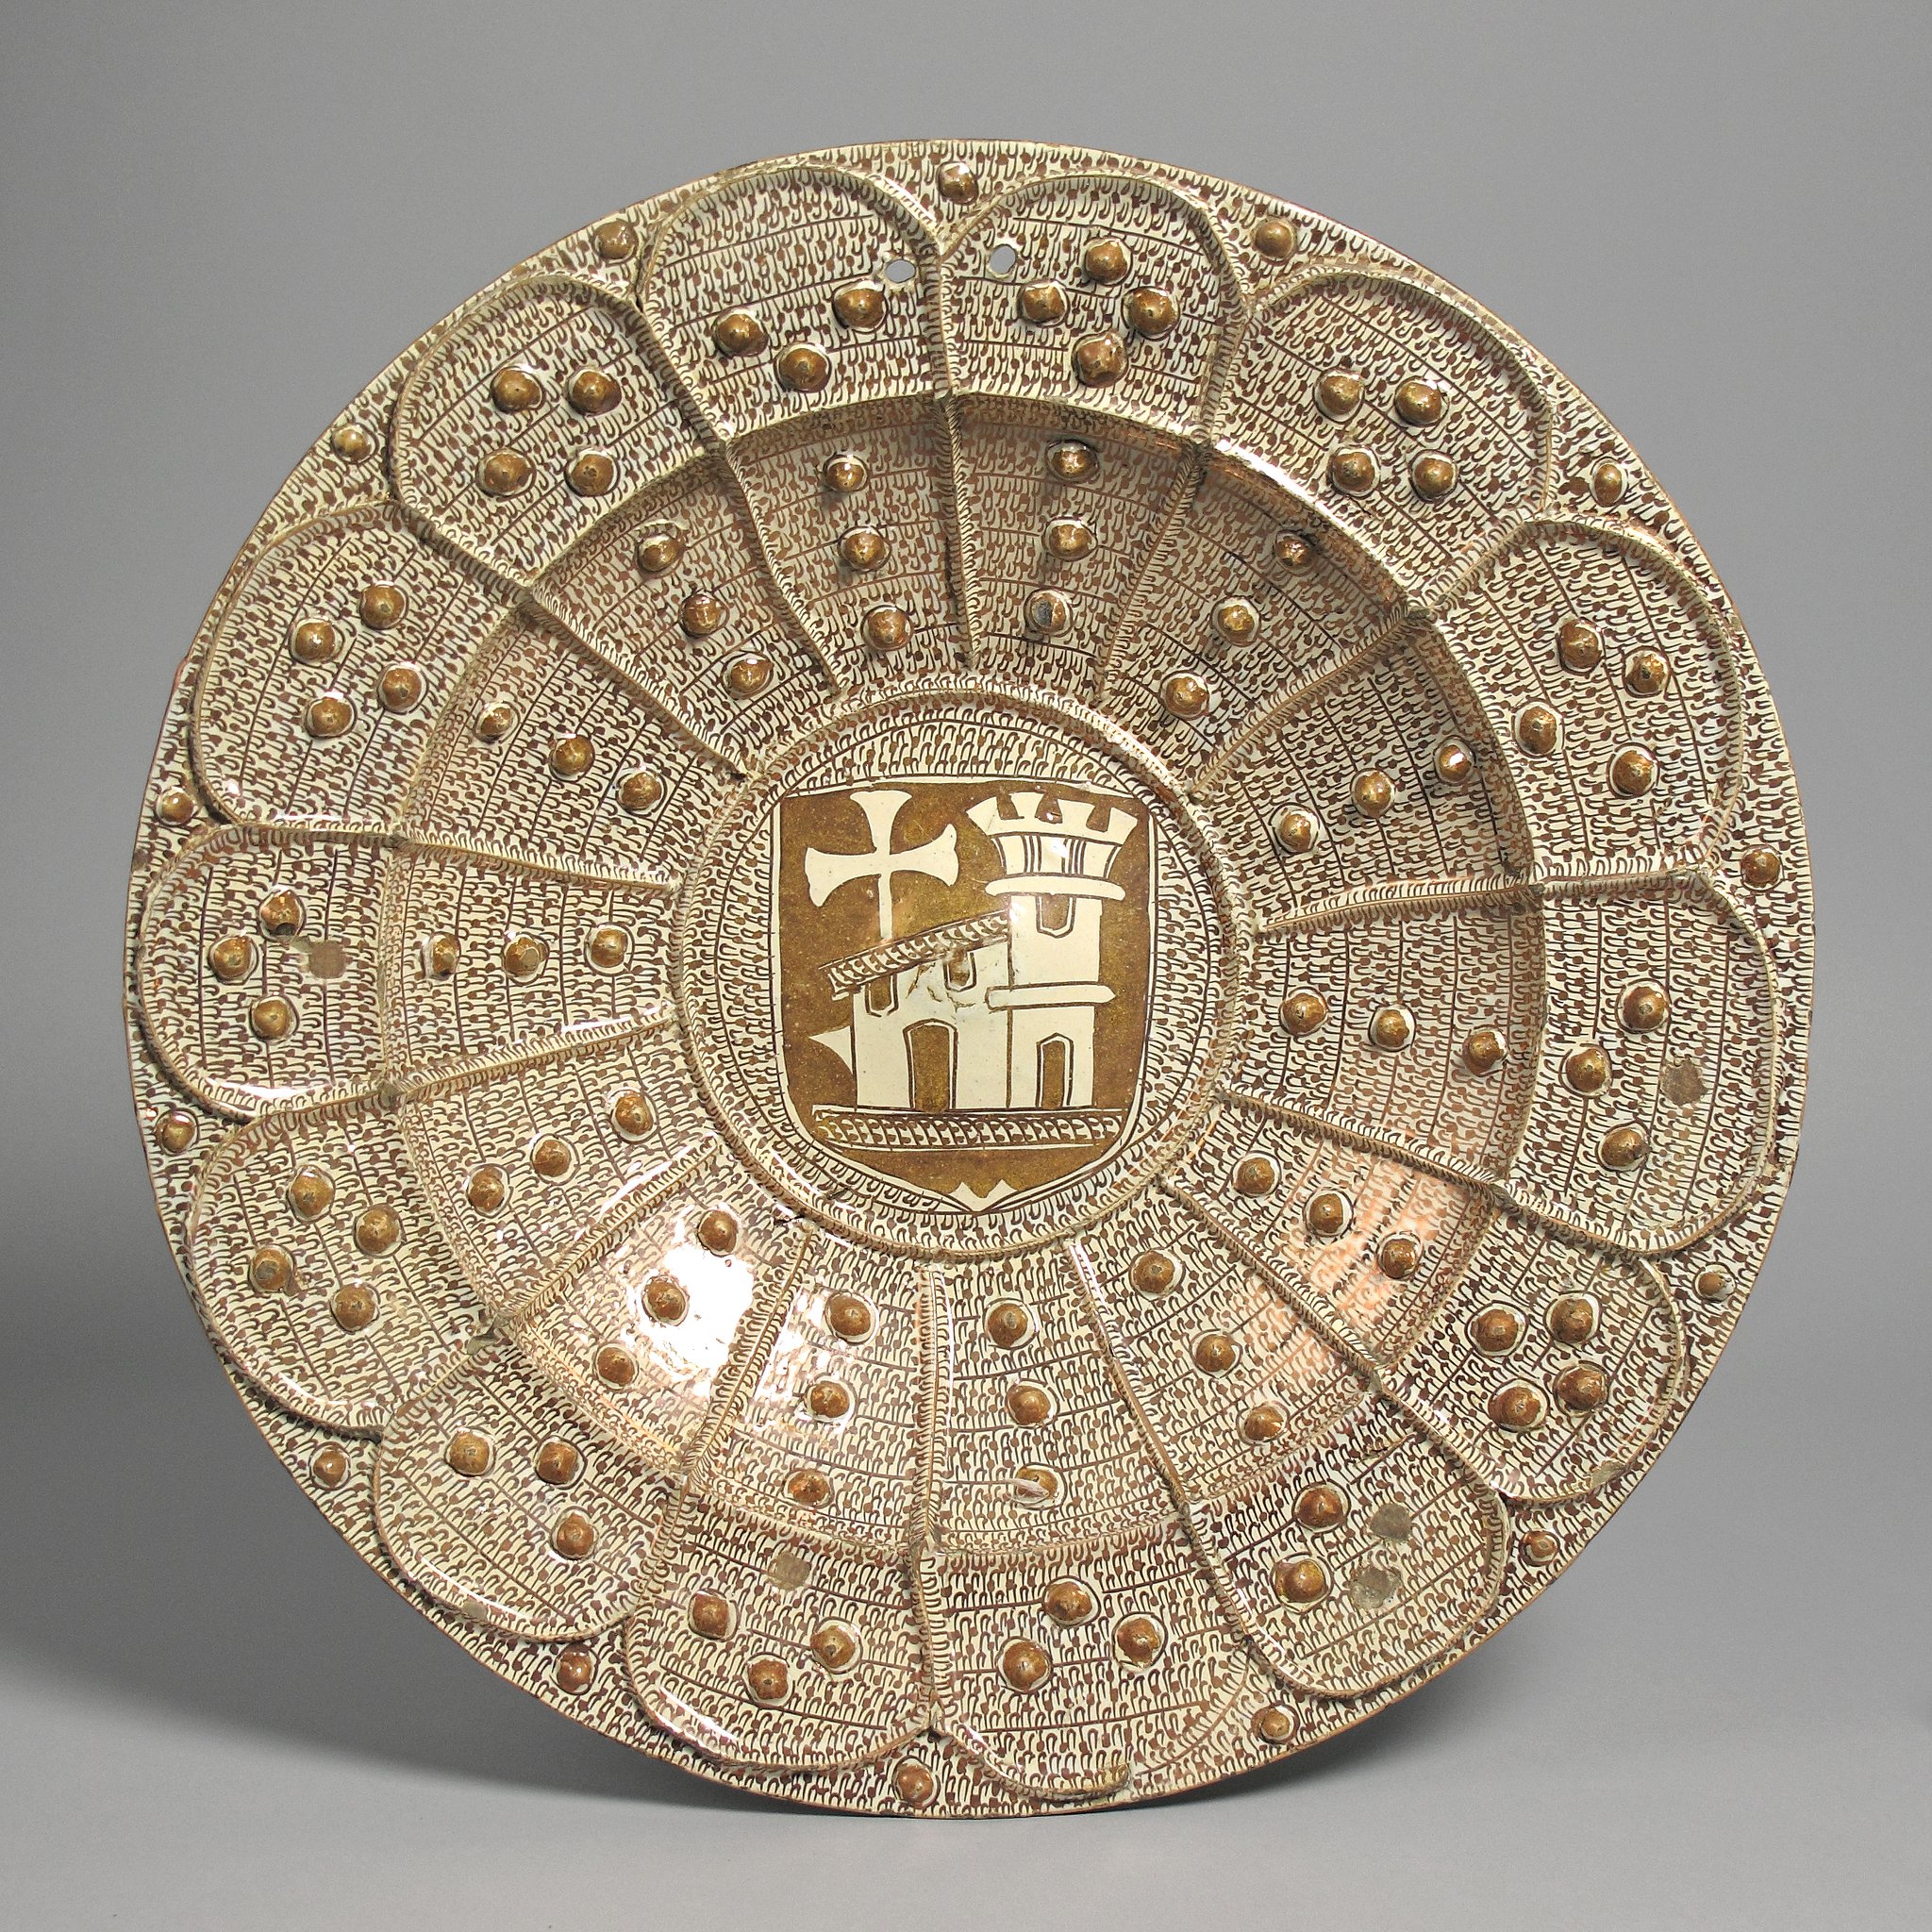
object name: dish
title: Dish with Unidentified Coat of Arms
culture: spanish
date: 1470-1490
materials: earthenware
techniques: glazing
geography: spain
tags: coat of arms